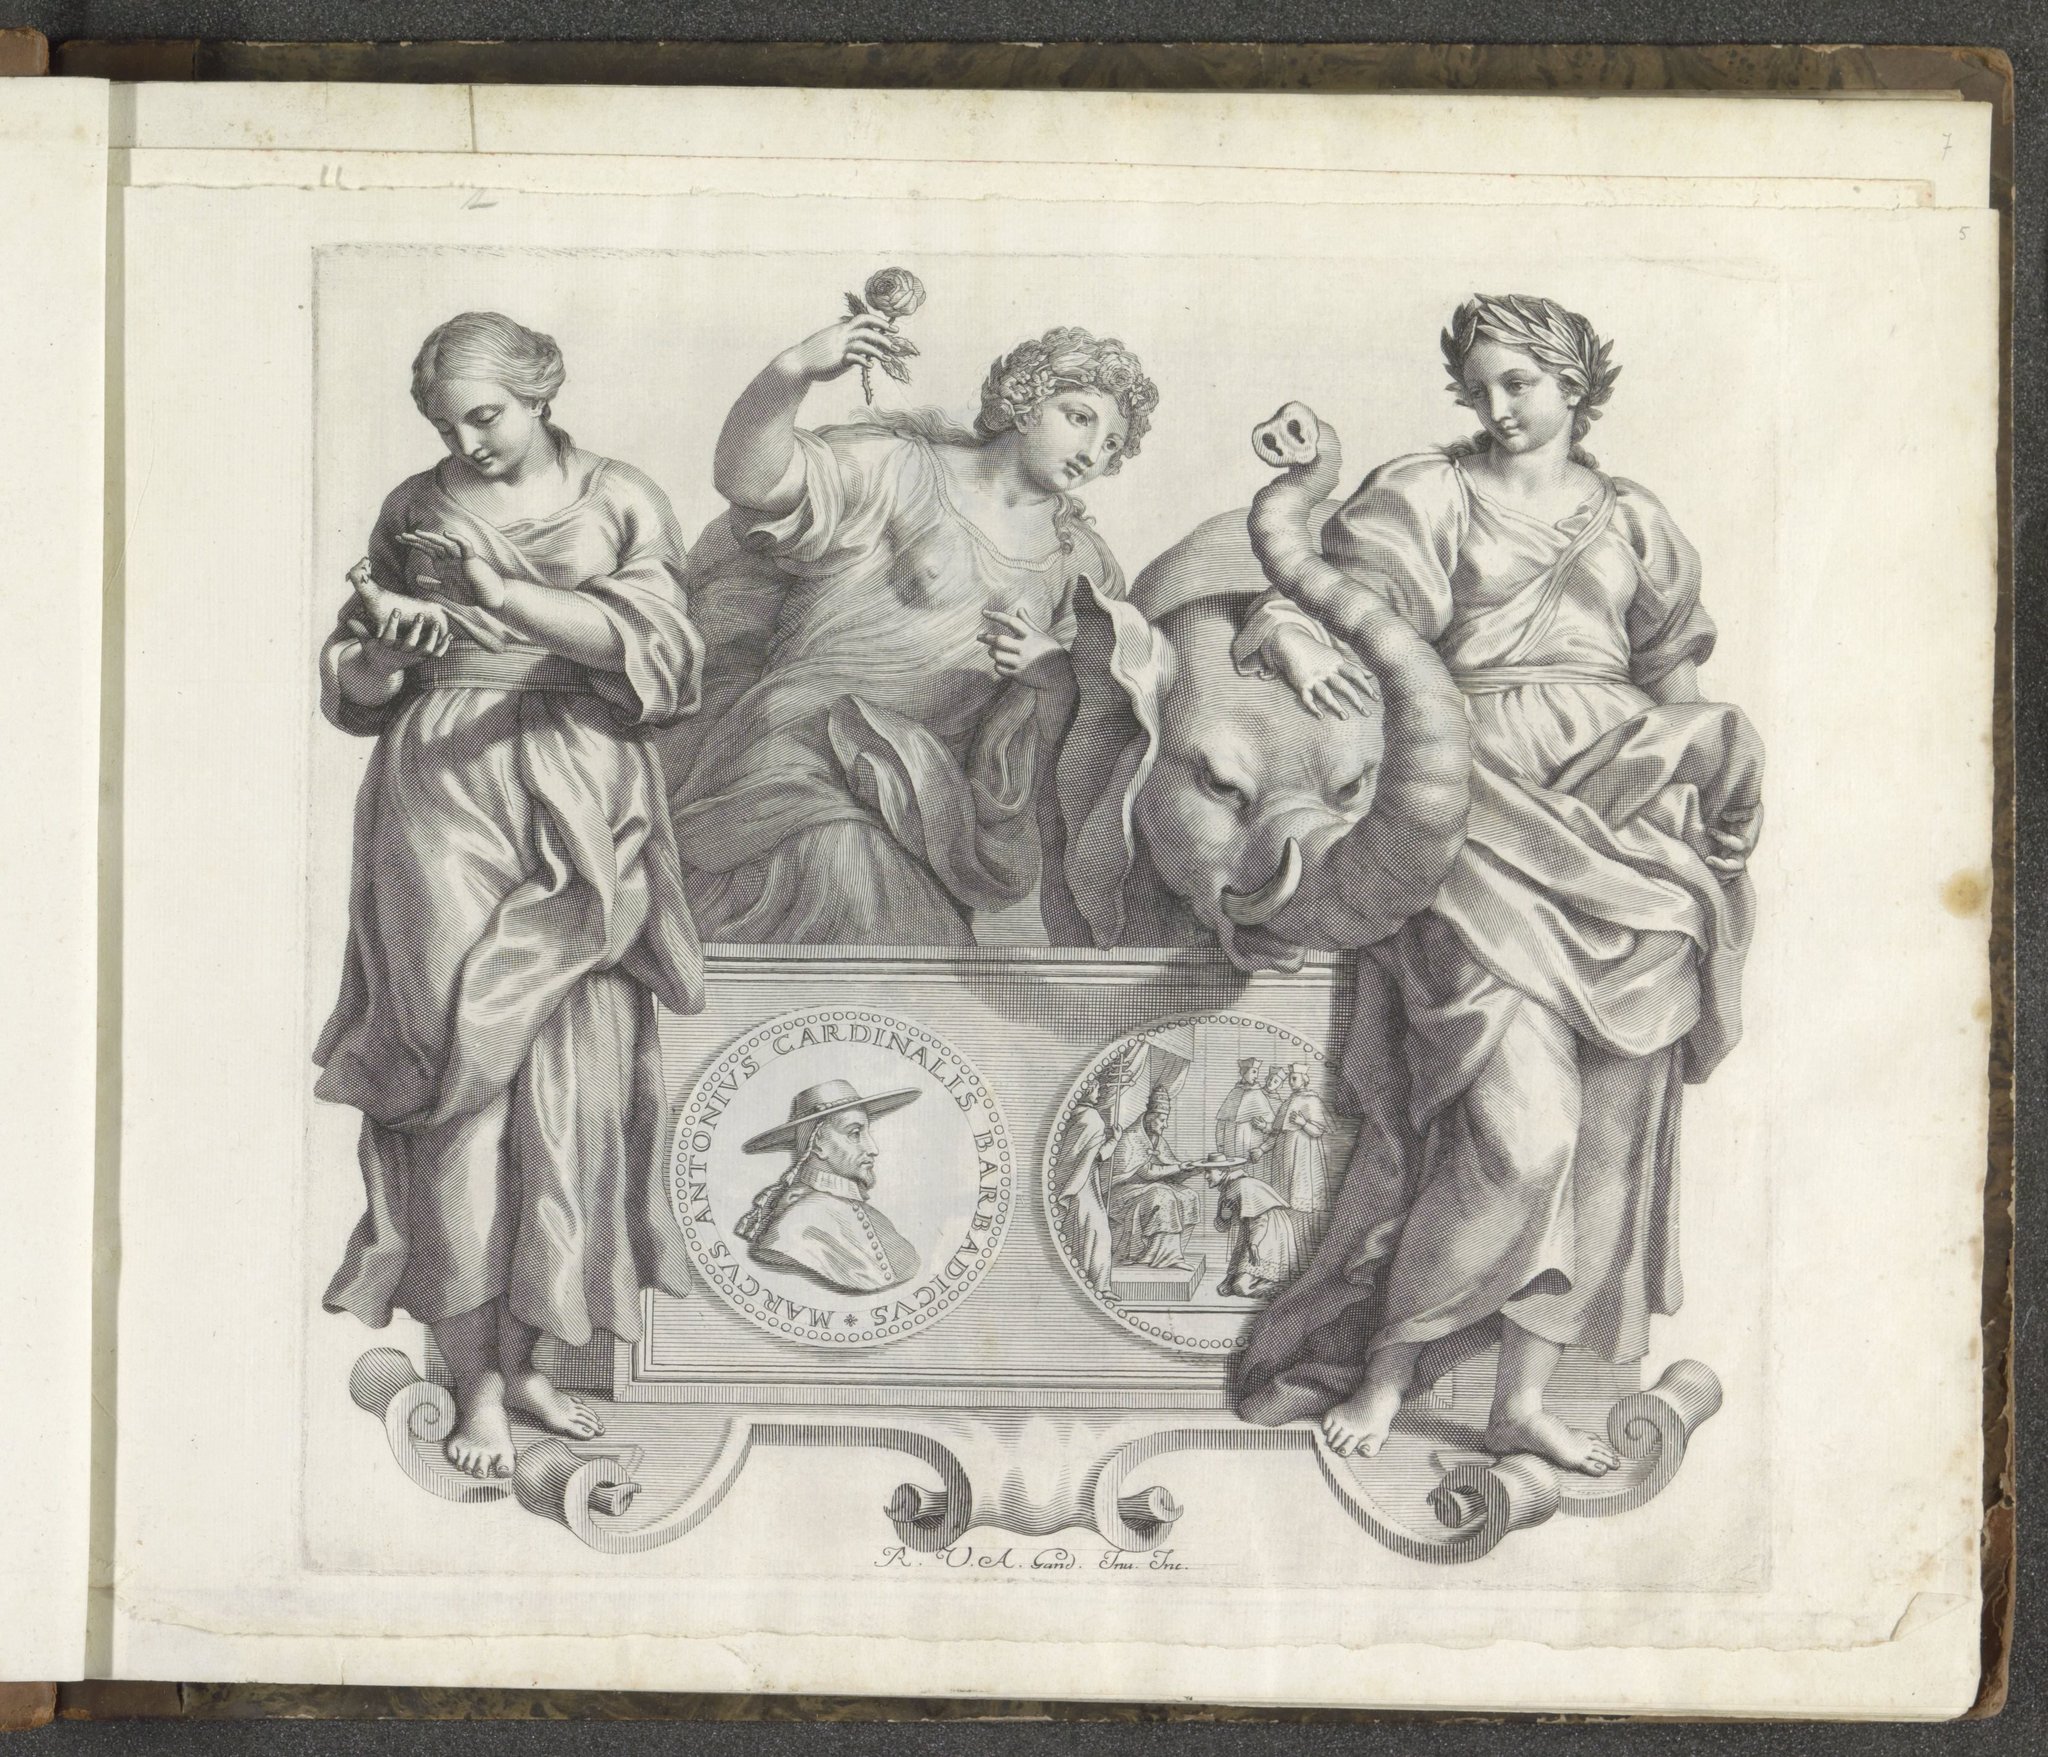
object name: album leaf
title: Portret van Marcantonio Barbarigo en de personificaties van Beleefdheid, Vriendelijkheid en Zachtmoedigheid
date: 1673-1743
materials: paper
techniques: engraving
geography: rome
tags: meekness; 'mansuetudine' (ripa), friendliness, gentleness, affability; 'affabilità, piacevolezza, amabilità', 'animo piacevole, trattabile & amorevole', 'benignità' (ripa), humanity, politeness; 'cortesia', 'humanità' (ripa), medal (considered as a piece of sculpture, regardless of its specific function), flowers: rose, gratitude; 'gratitudine', 'memoria grata de beneficii ricevuti' (ripa), trunked animals: elephant, abstract ideas and concepts (+ personification)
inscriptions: collector's mark: Lugt 2228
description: Voetstuk in de vorm van een cartouche. Daarop een penning met op de voorzijde het portret van kardinaal Marcantonio Barbarigo. Op de keerzijde knielt de kardinaal voor de paus en wordt hij benoemd. Het voetstuk wordt omringd door drie vrouwelijke personificaties. Links de personificatie van Beleefdheid (Humanita). Zij liefkoost een hondje. De vrouw in het midden is de vrouwelijke personificatie van Vriendelijkheid of Gespraakzaamheid. Rechts staat Zachtmoedigheid: een vrouw met een lauwerkrans op haar hoofd en haar hand op de kop van een olifant. De prent maakt deel uit van een album.